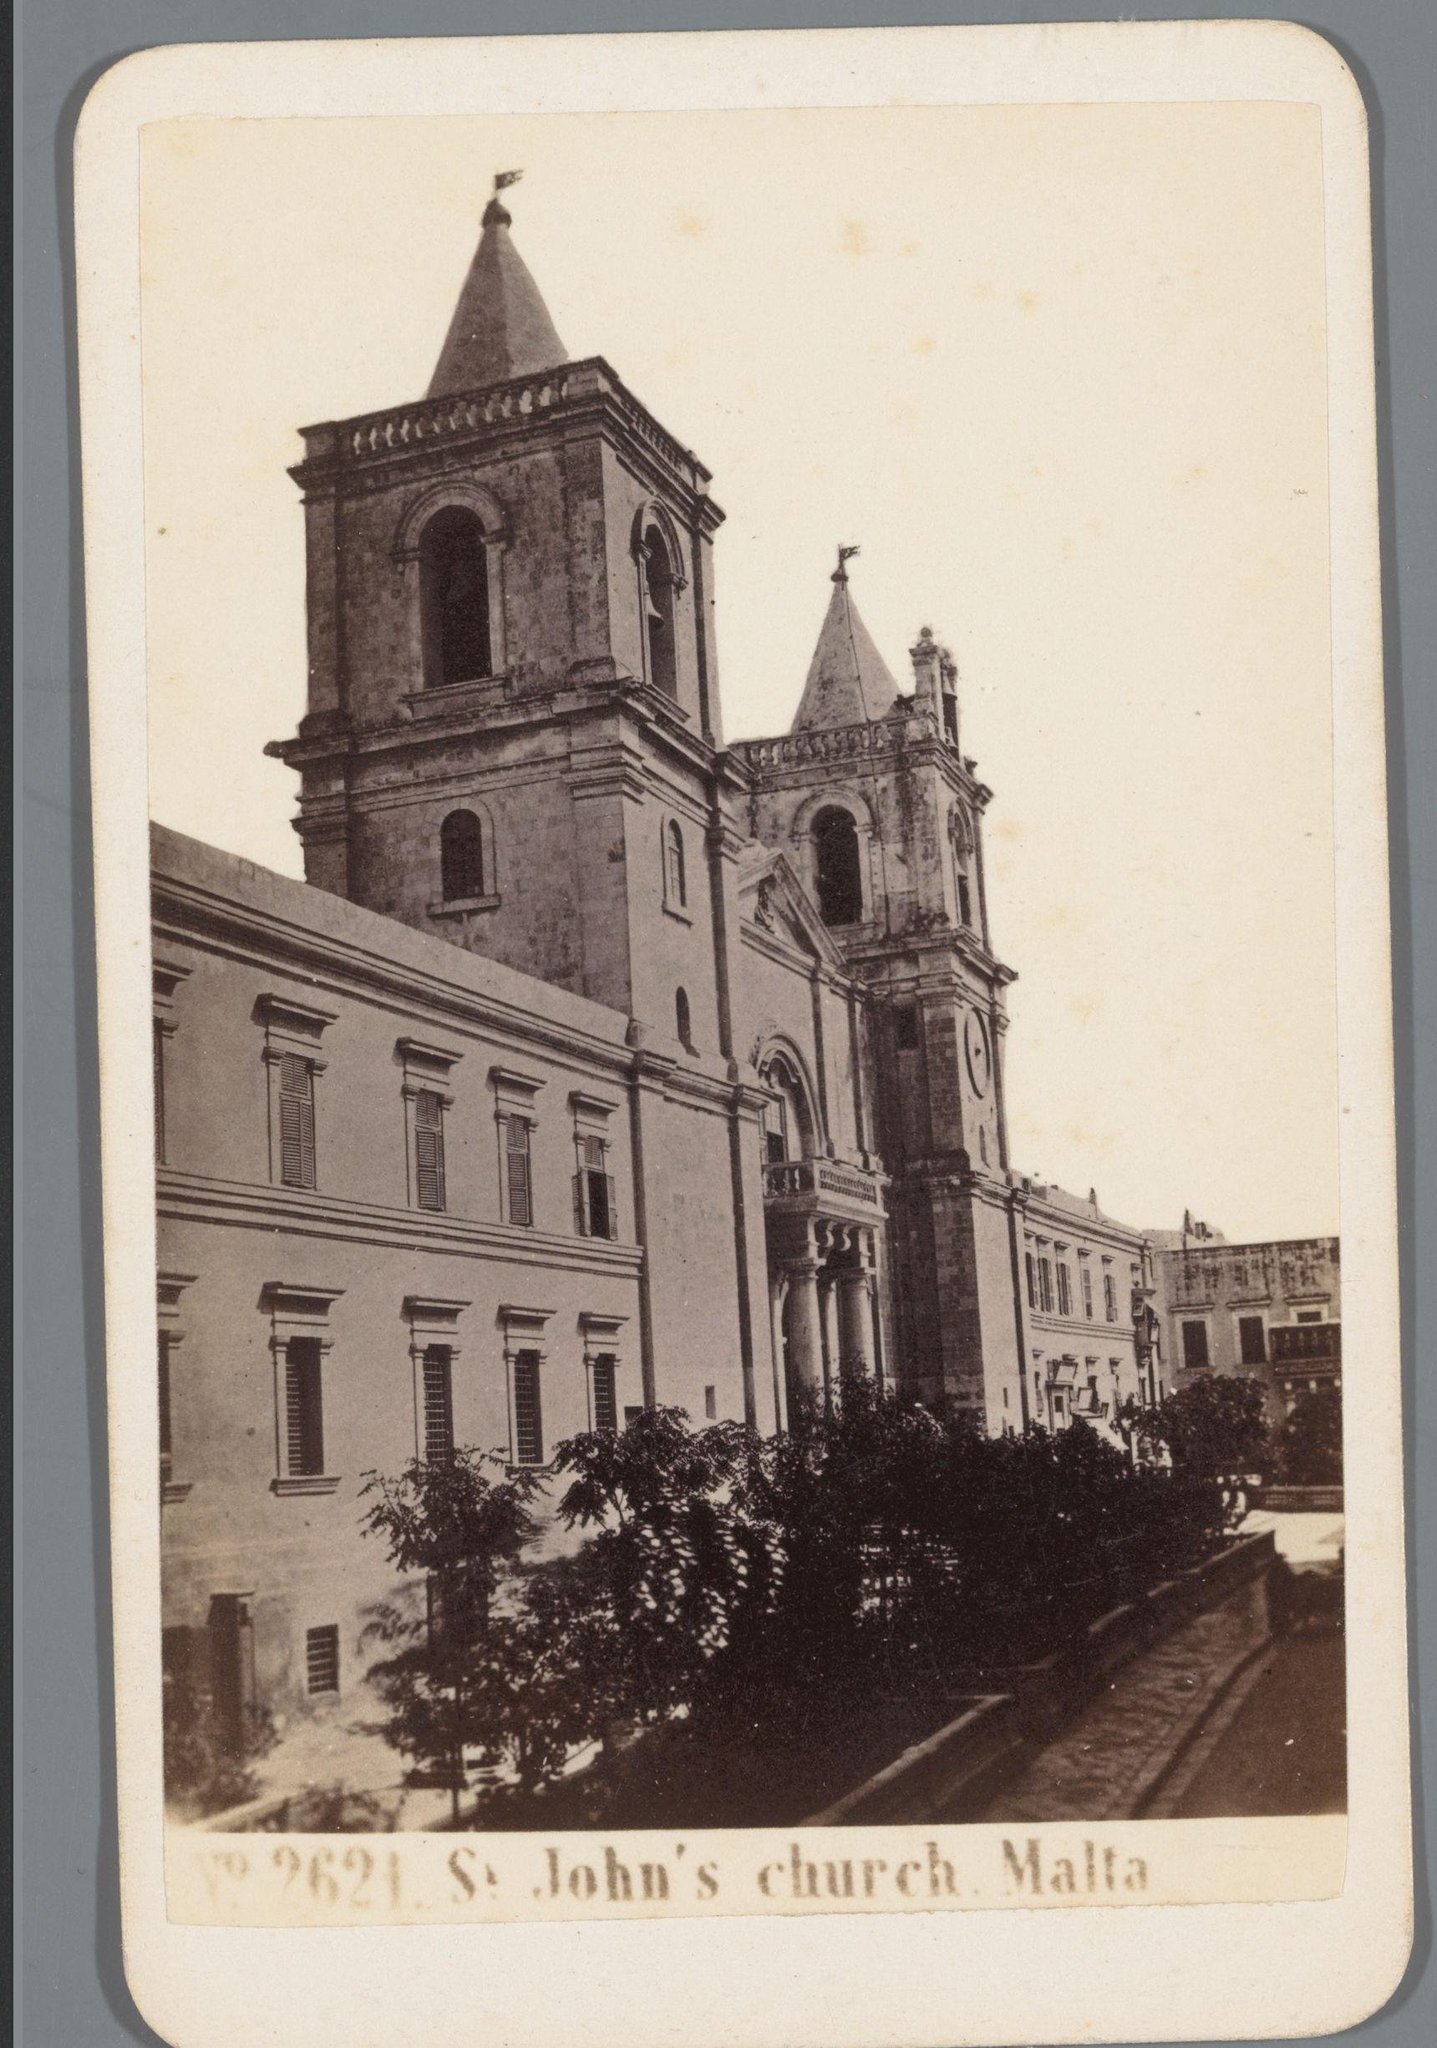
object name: photograph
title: Sint-Janscokathedraal, Valletta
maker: giorgio sommer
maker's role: fotograaf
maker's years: 1834-1914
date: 1865-1888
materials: cardboard, paper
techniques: albumen print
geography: valletta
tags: church (exterior)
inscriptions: number: ‘No. 2621.’, inscription: ‘Grandes Médailles d'or/ Georges Sommer/ Photographe/ Naples/ Atelier Monte di Dio No. 4 au 1er/ Magasin Sta. Caterina No. 5./ Lit. Richter & Co.’